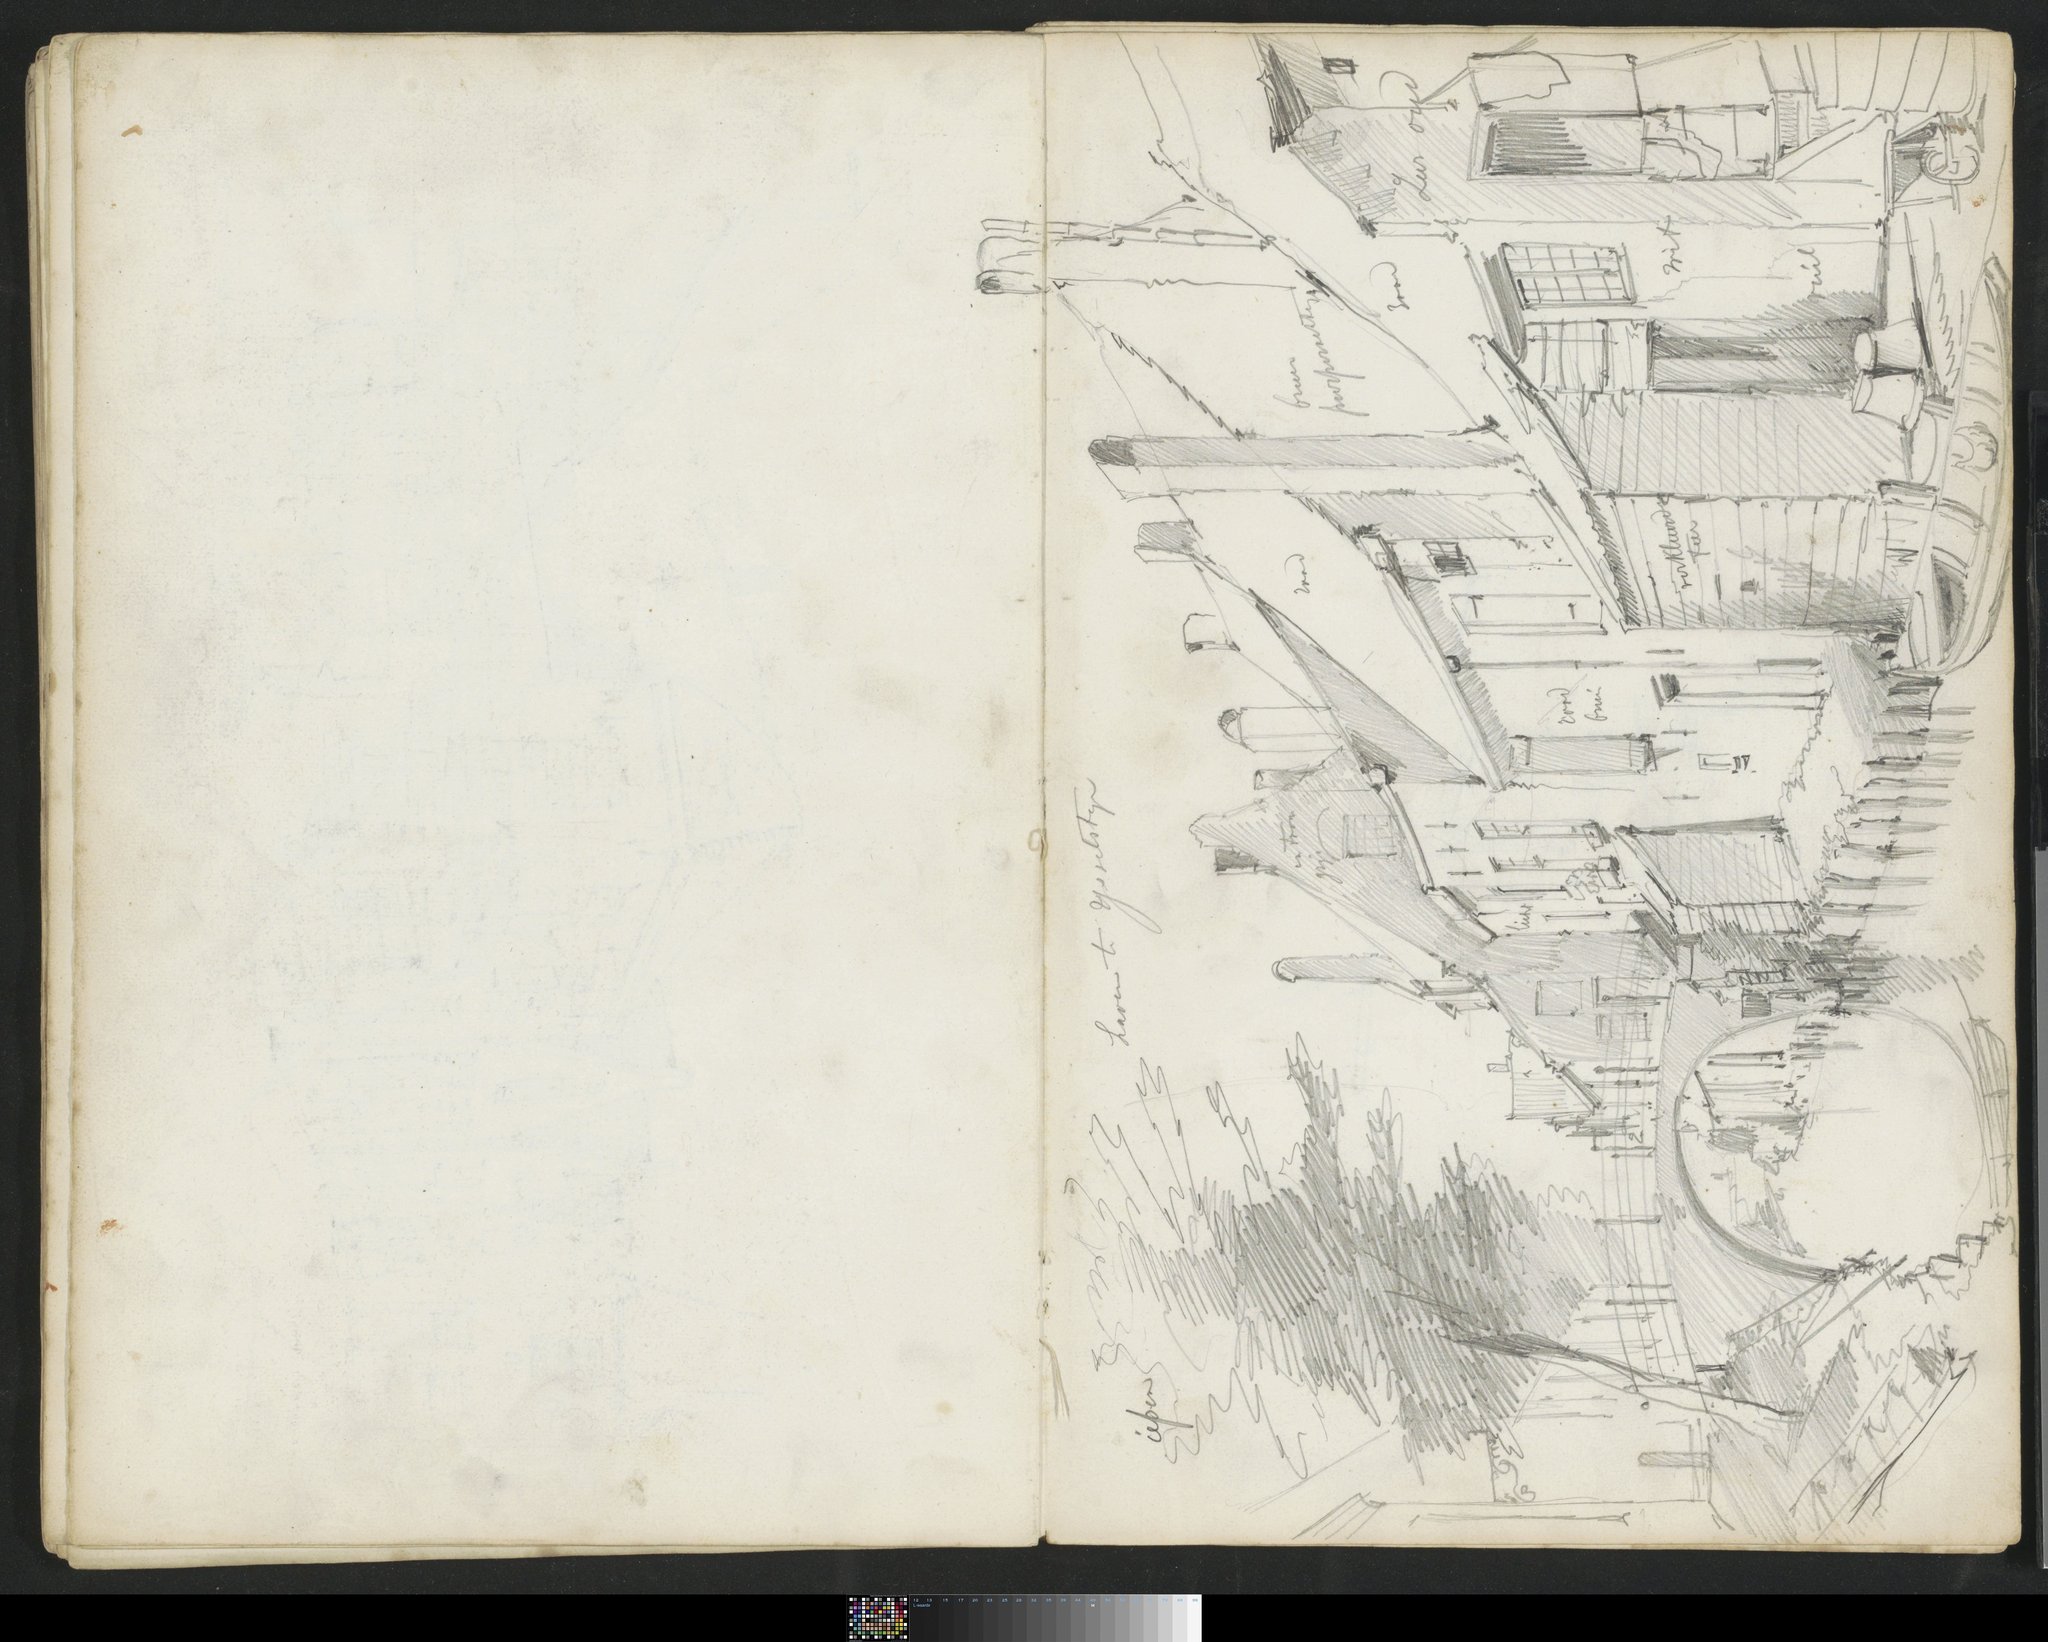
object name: sketchbook leaf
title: Brug bij de haven van IJsselstein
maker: willem koekkoek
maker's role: draughtsman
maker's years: 1839-1895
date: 1849-1895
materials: paper, pencil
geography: ijsselstein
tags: the usual house or row of houses, bridge in city across river, canal, etc.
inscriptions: annotation: ‘haven te Ysselstyn/ iepen’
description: Blad 23 verso en 24 recto uit een schetsboek met 42 bladen.